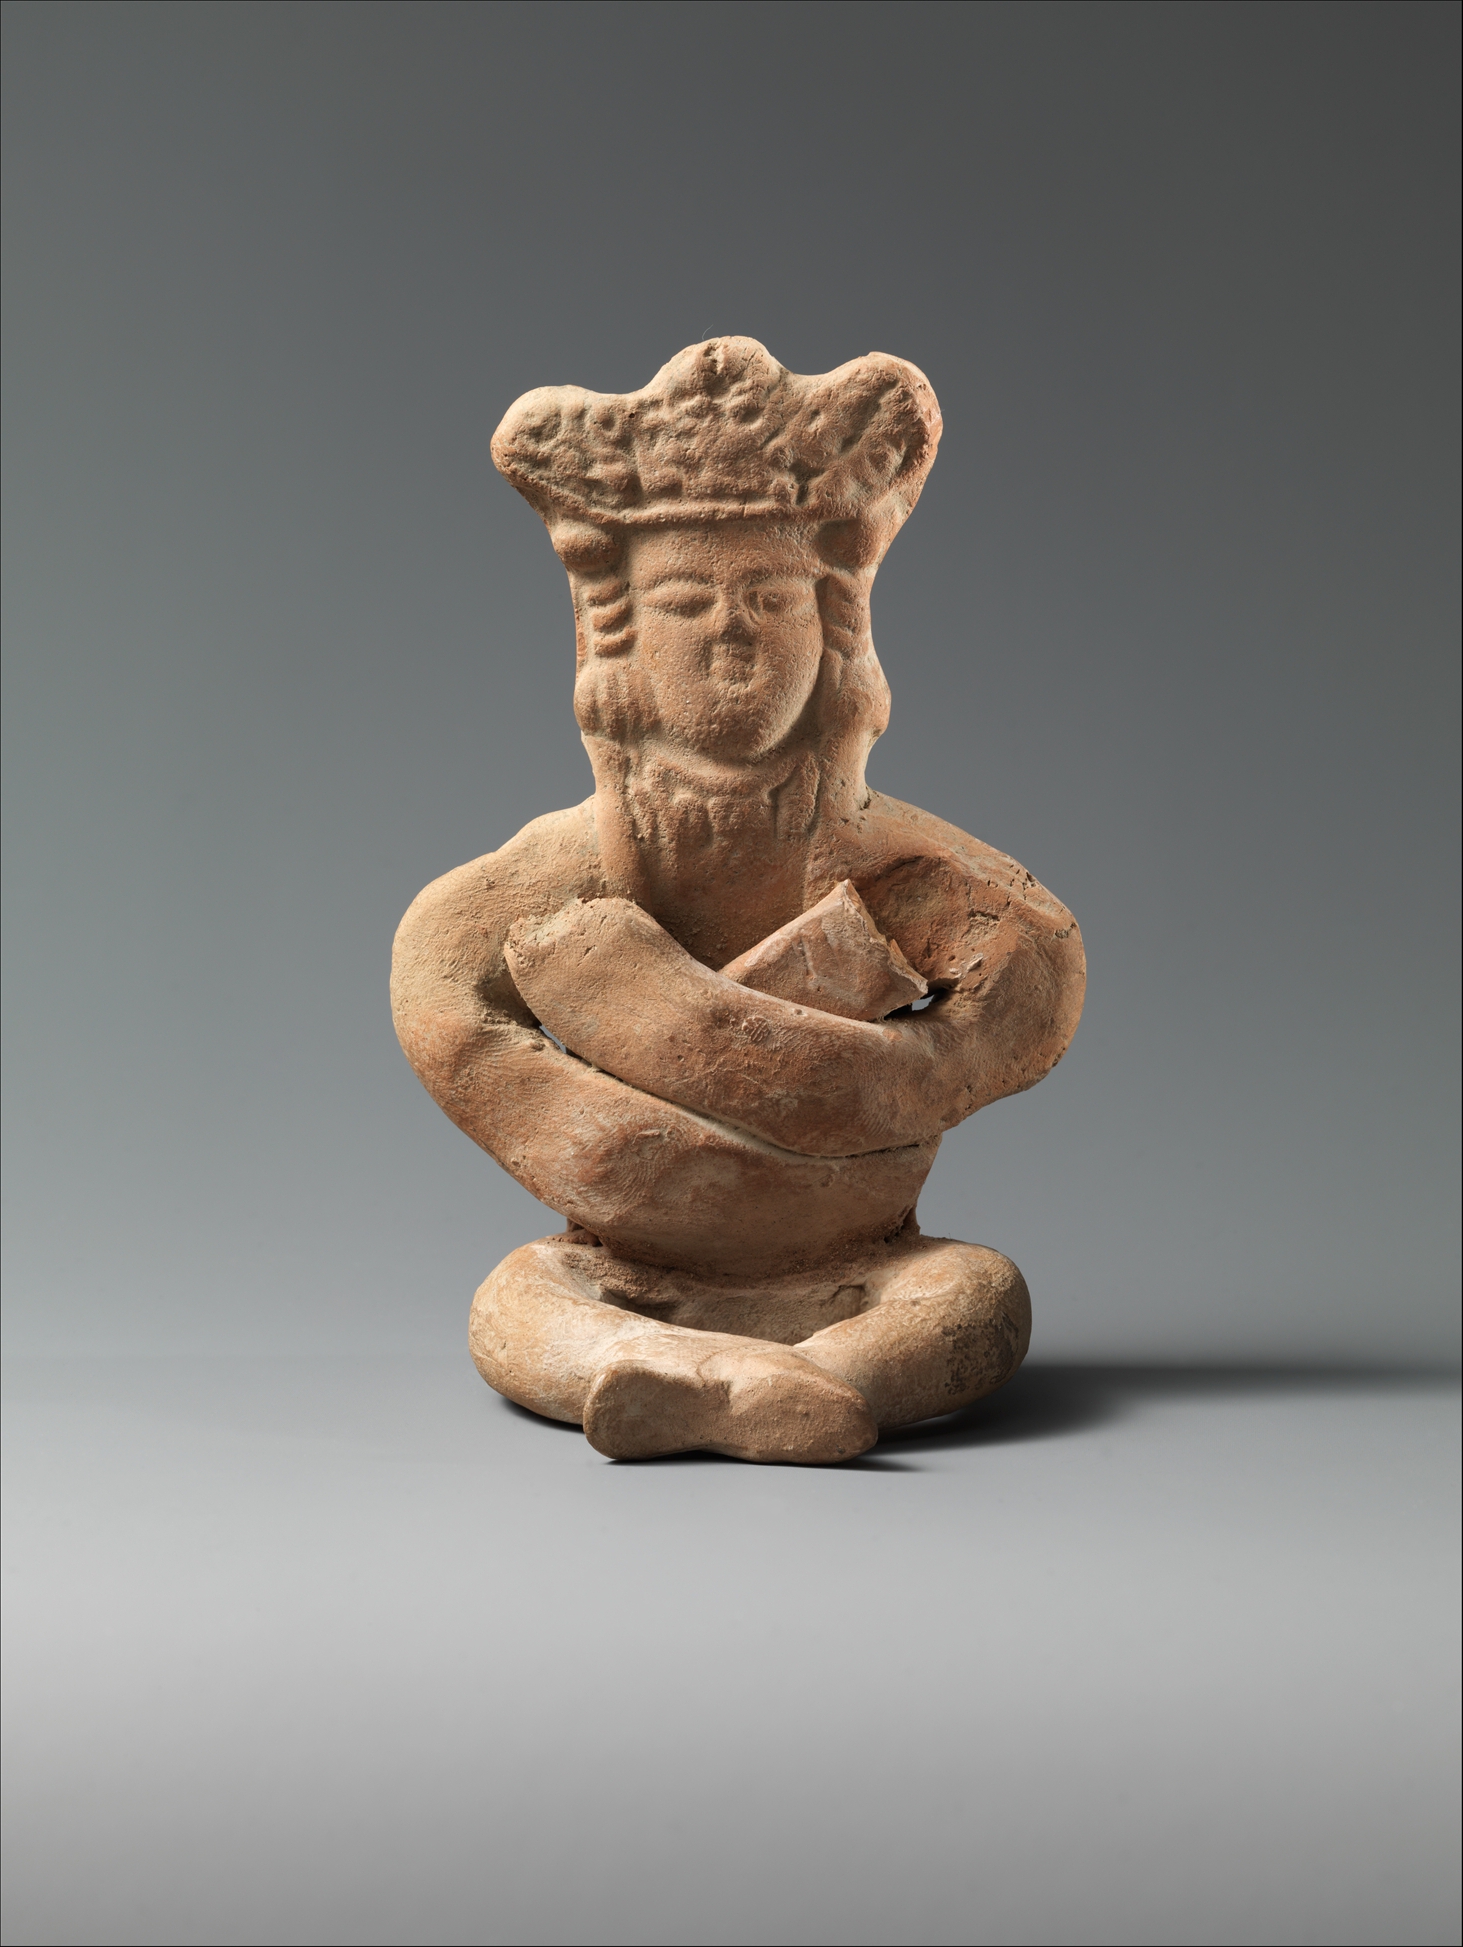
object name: figure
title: Figurine of a Seated Personage with Folded Arms and Elaborate Headdress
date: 1101-1300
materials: earthenware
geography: iran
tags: men